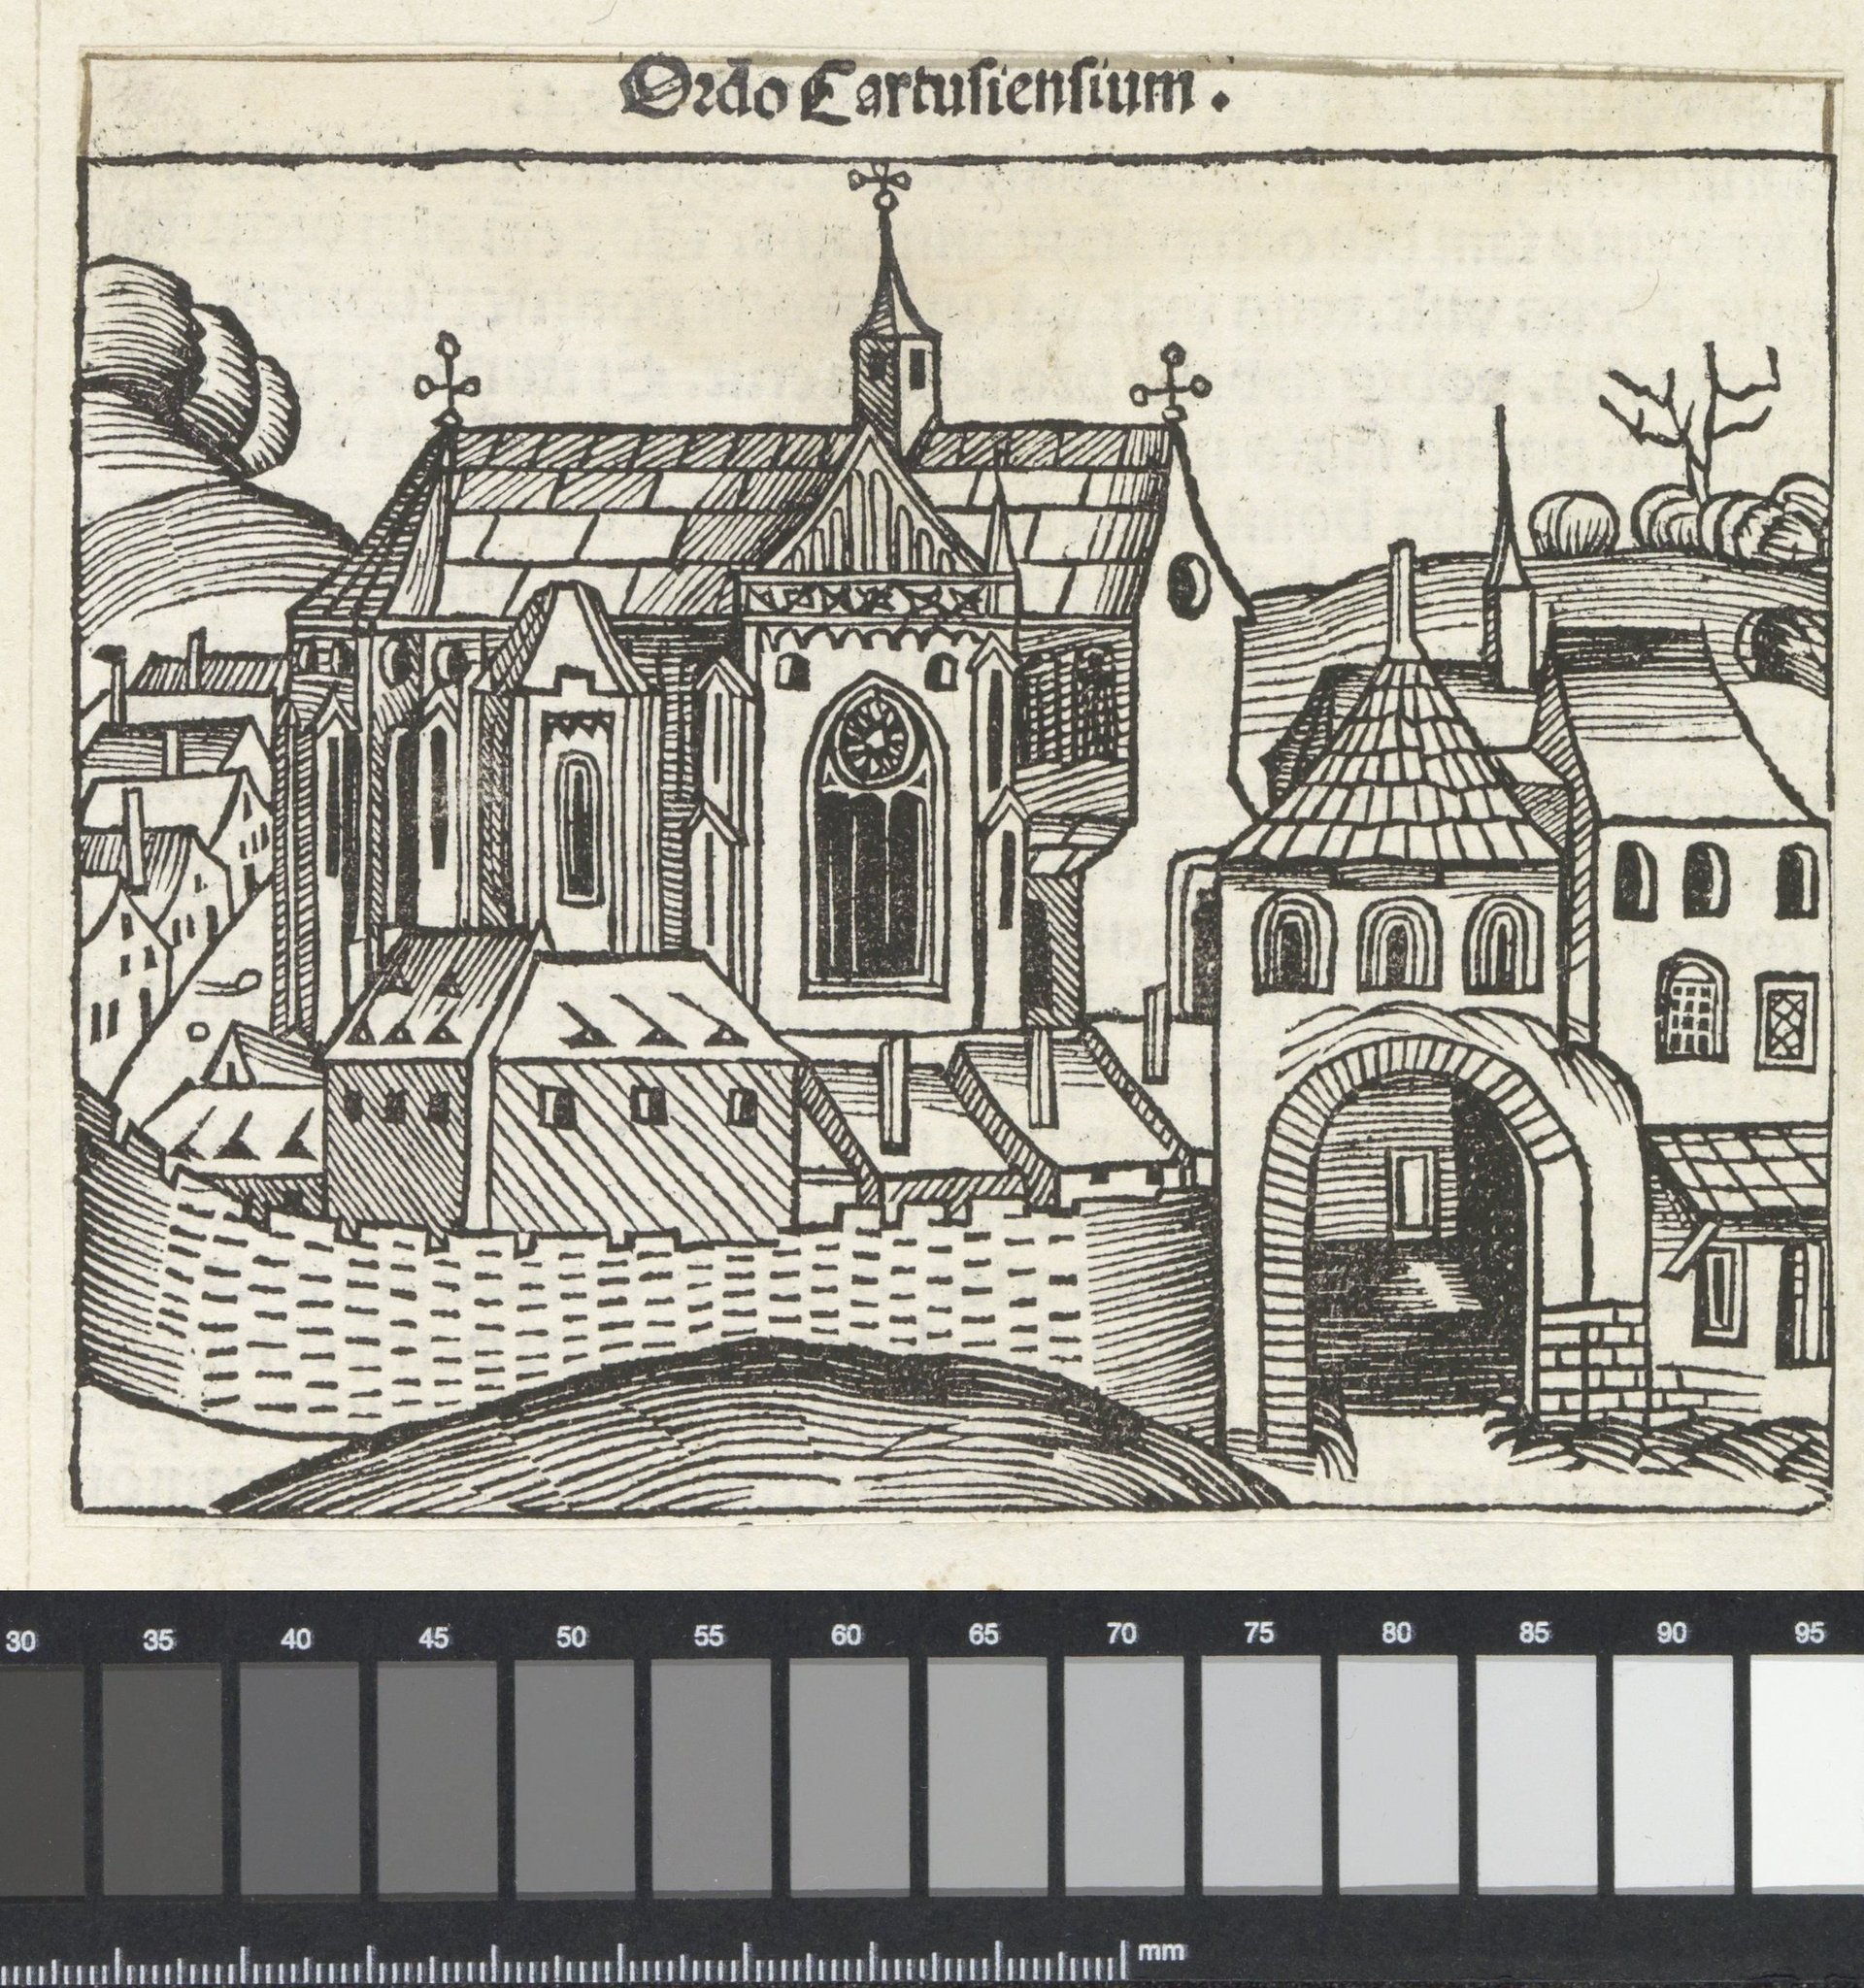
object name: print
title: Orde van de kartuizers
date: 1493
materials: paper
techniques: letterpress printing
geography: nuremberg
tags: abbey, monastery, convent ~ roman catholic church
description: De houtsnede wordt herhaaldelijk gebruikt als boekillustratie in de Liber Chronicarum (of Neurenbergkroniek) van Hartmann Schedel, verschenen in het Latijn en Duits in 1493. Zie de Latijnse uitgave, folio 194r.